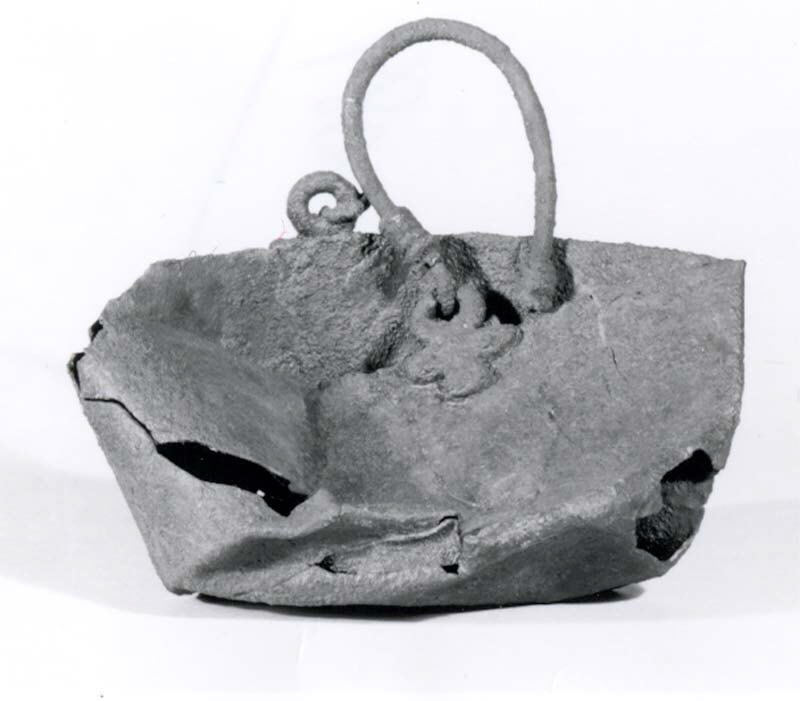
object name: bucket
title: Bucket with attachments and handle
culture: iranian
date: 900-801 BCE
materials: bronze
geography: iran